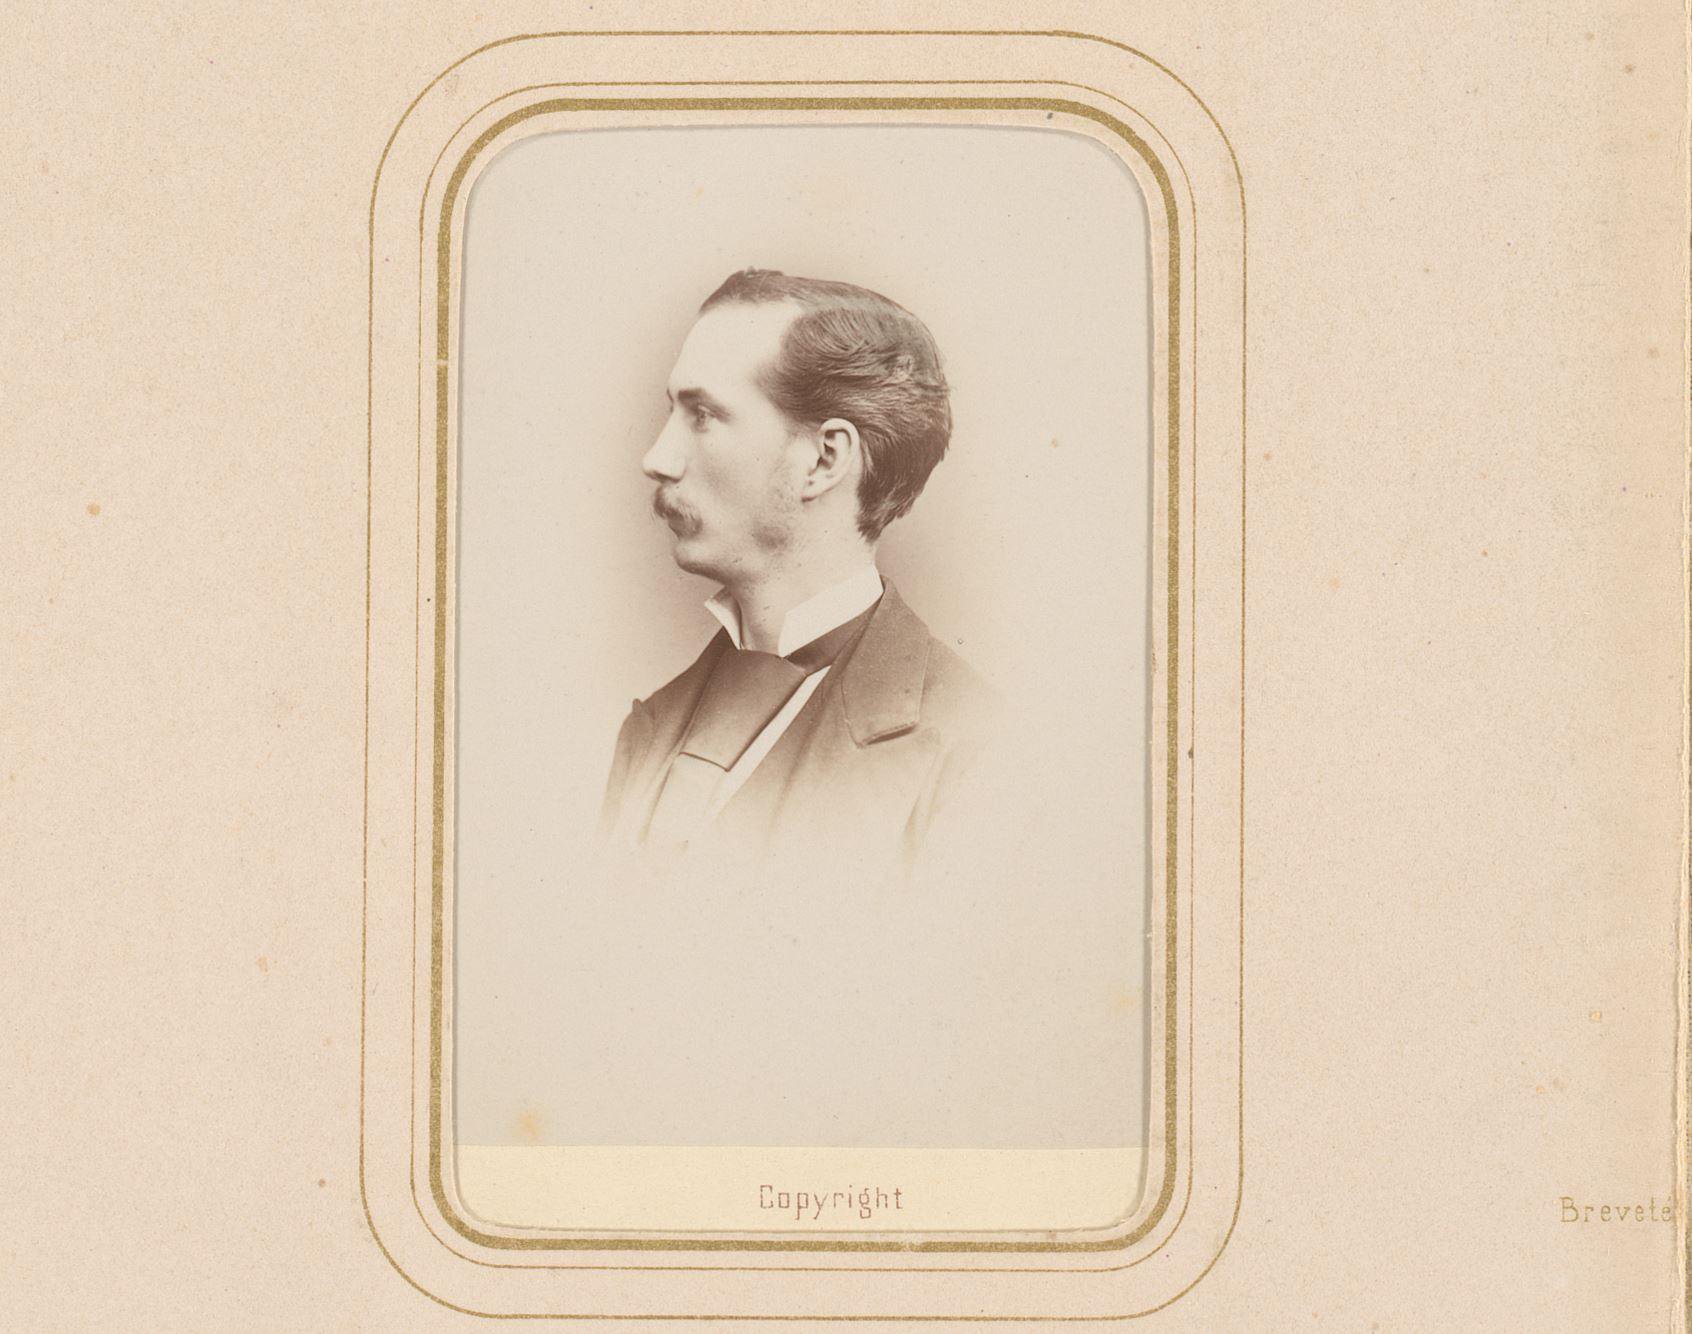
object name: carte de visite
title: Portret van een man met snor, en profil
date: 1804-1873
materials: cardboard, photographic support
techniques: albumen print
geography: southampton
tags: moustache, historical persons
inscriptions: inscription: ‘SOUTH OF ENGLAND PHOTOGRAPHIC INSTITUTION/ ADAMS & STILLIARD/ Artists &/ Photographers/ 9 Bernard Street/ Southampton/ quote this date/ when ordering after copies’, date: ‘APR 1873’